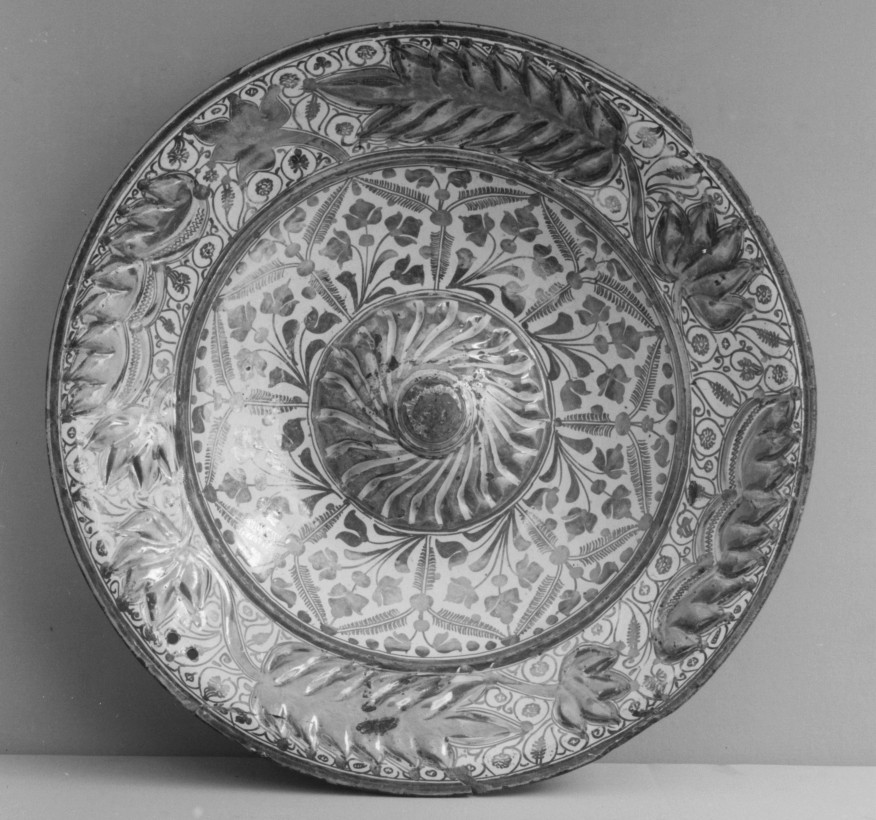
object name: plateau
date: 1601-1700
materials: earthenware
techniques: luster painting, glazing